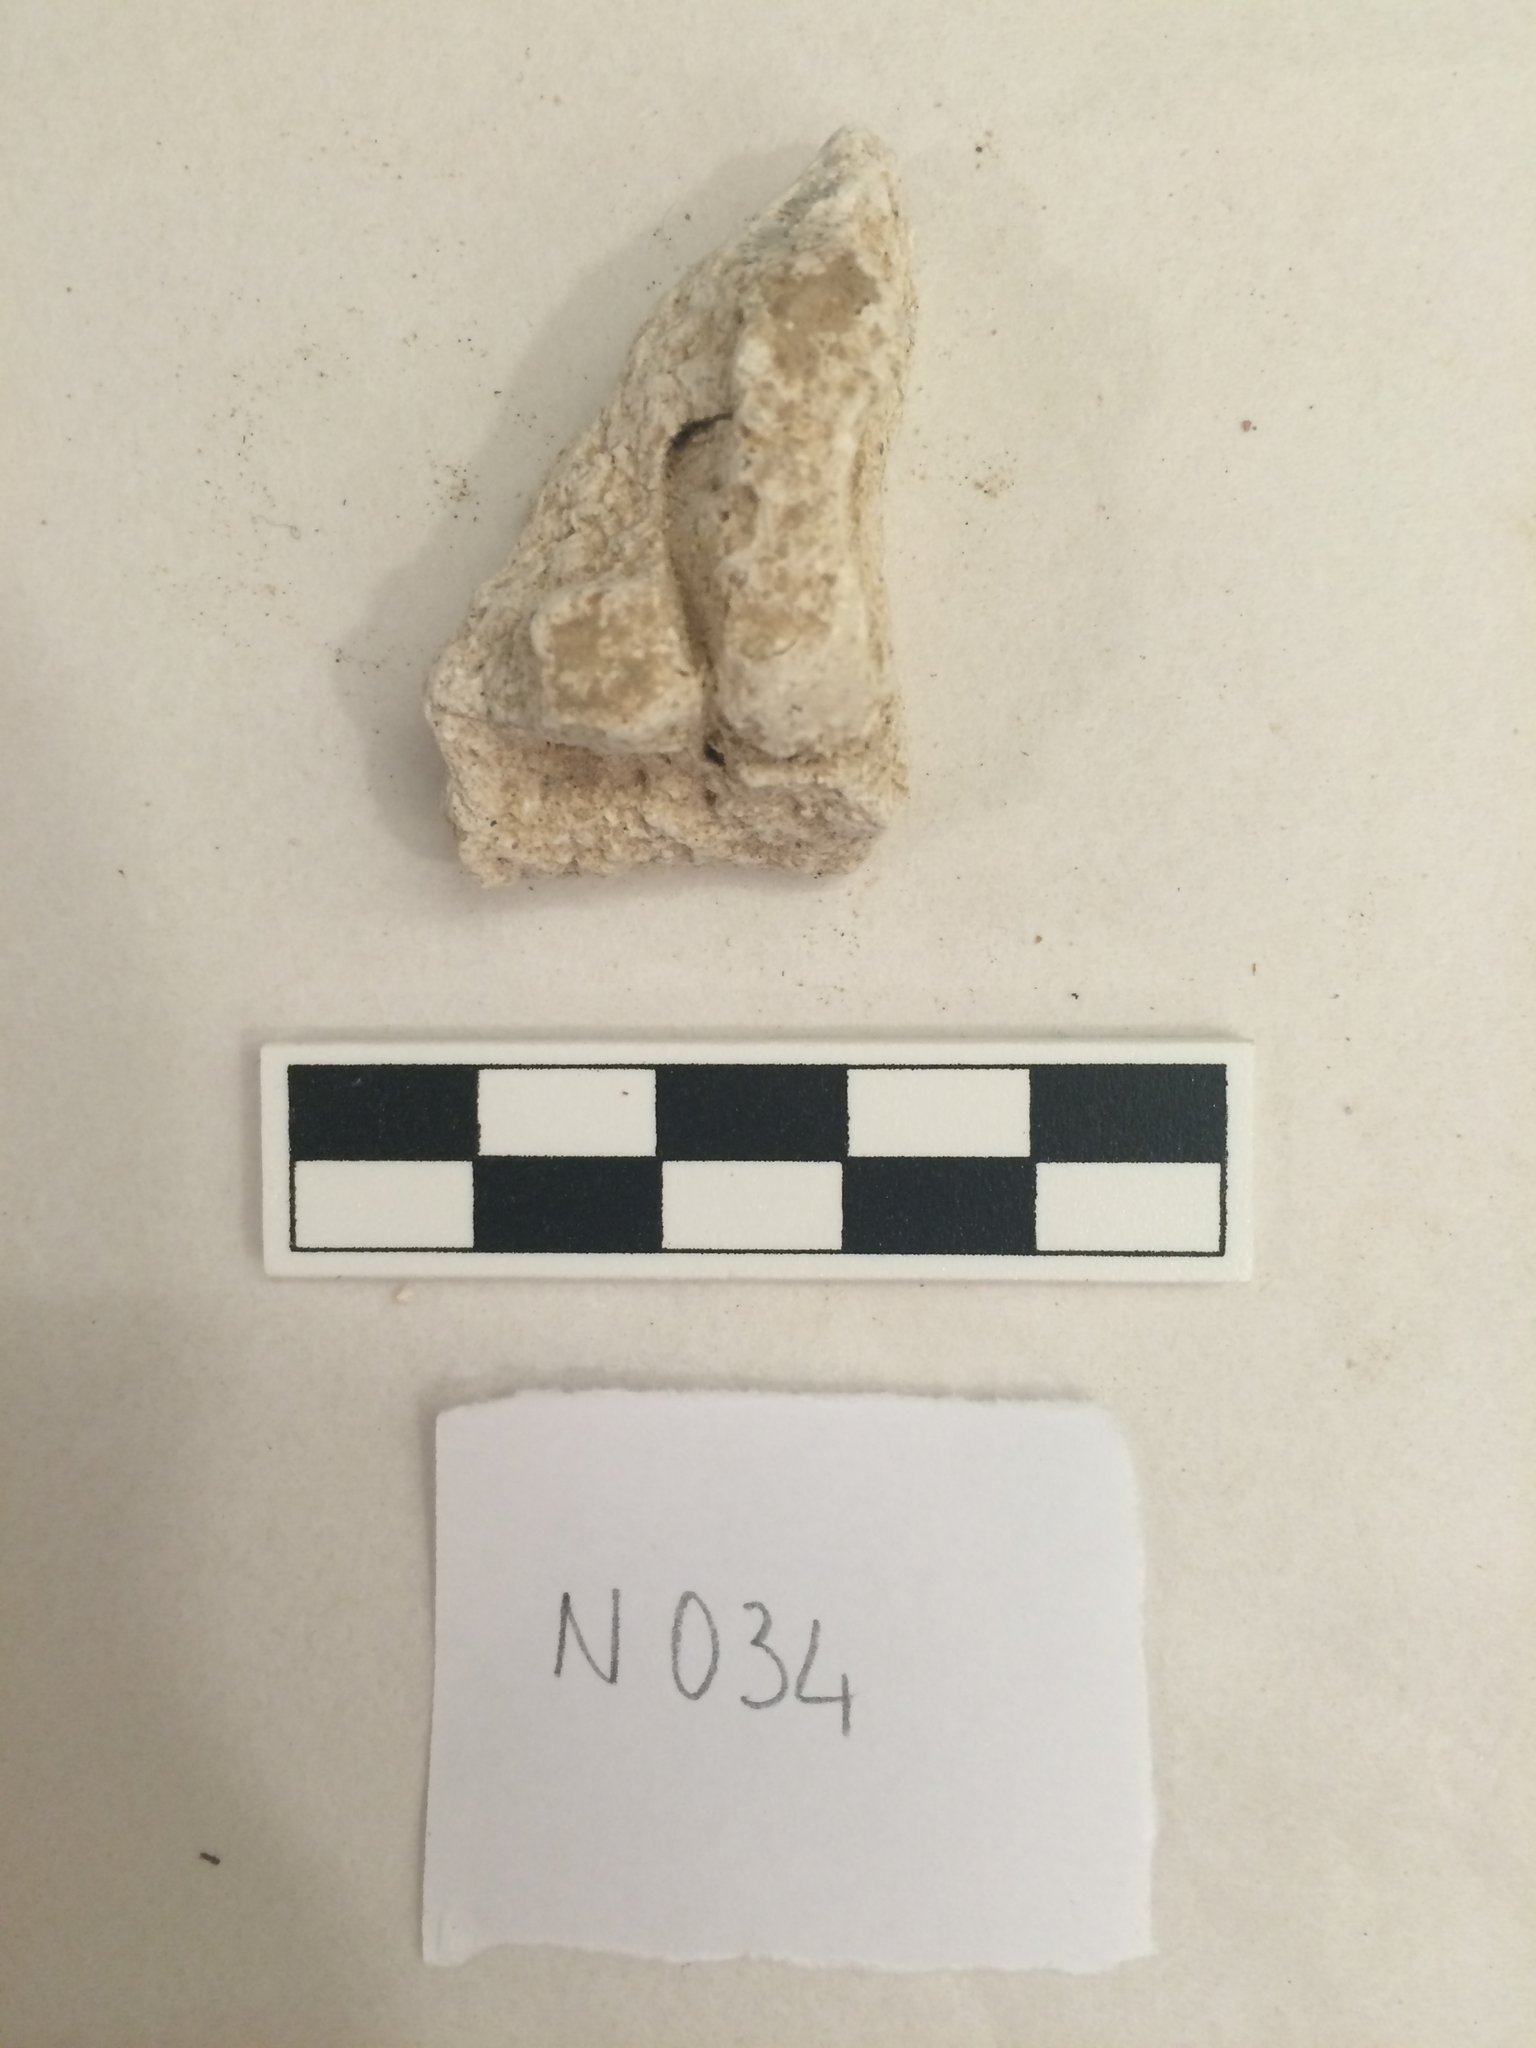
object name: fragment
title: Stucco Fragment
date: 701-1200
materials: plaster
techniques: carving, painting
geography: iran